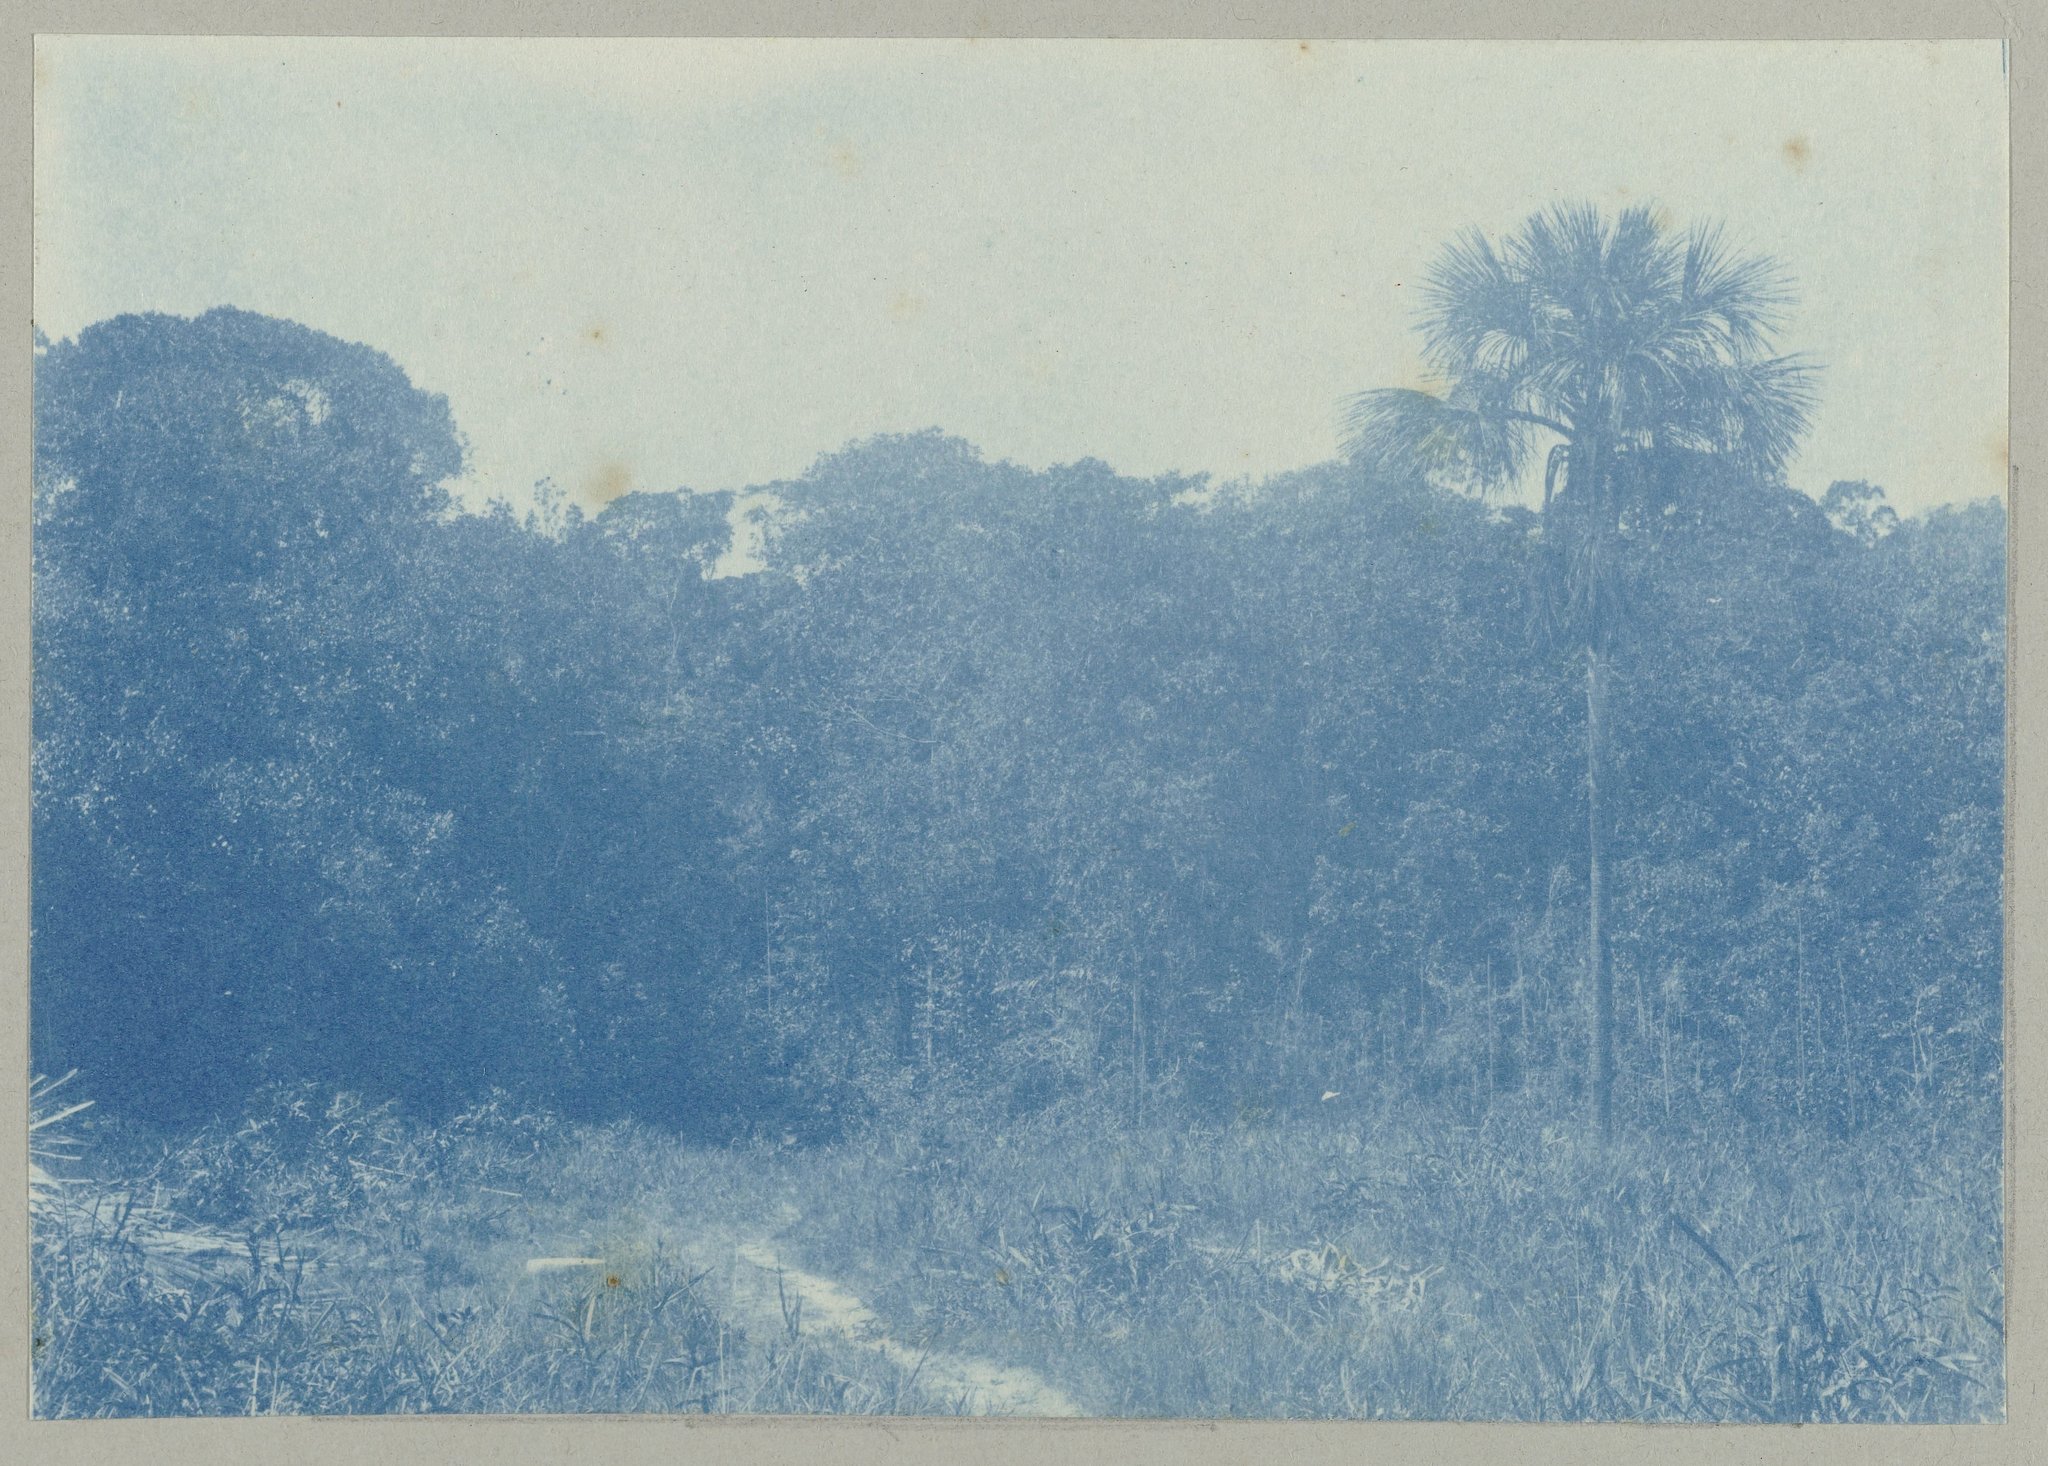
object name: photograph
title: Brownsweg verlaat de Patricksavanna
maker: hendrik doijer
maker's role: engineer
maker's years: 1863-1925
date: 1903-1910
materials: photographic support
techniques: cyanotype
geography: suriname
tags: suriname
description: Een pad, genaamd de Brownsweg, die vanuit de Patrick-savanna het bos in loopt. Onderdeel van het fotoalbum Souvenir de Voyage (deel 2), over het leven van de familie Doijer in en rond de plantage Ma Retraite in Suriname in de jaren 1903-1910.